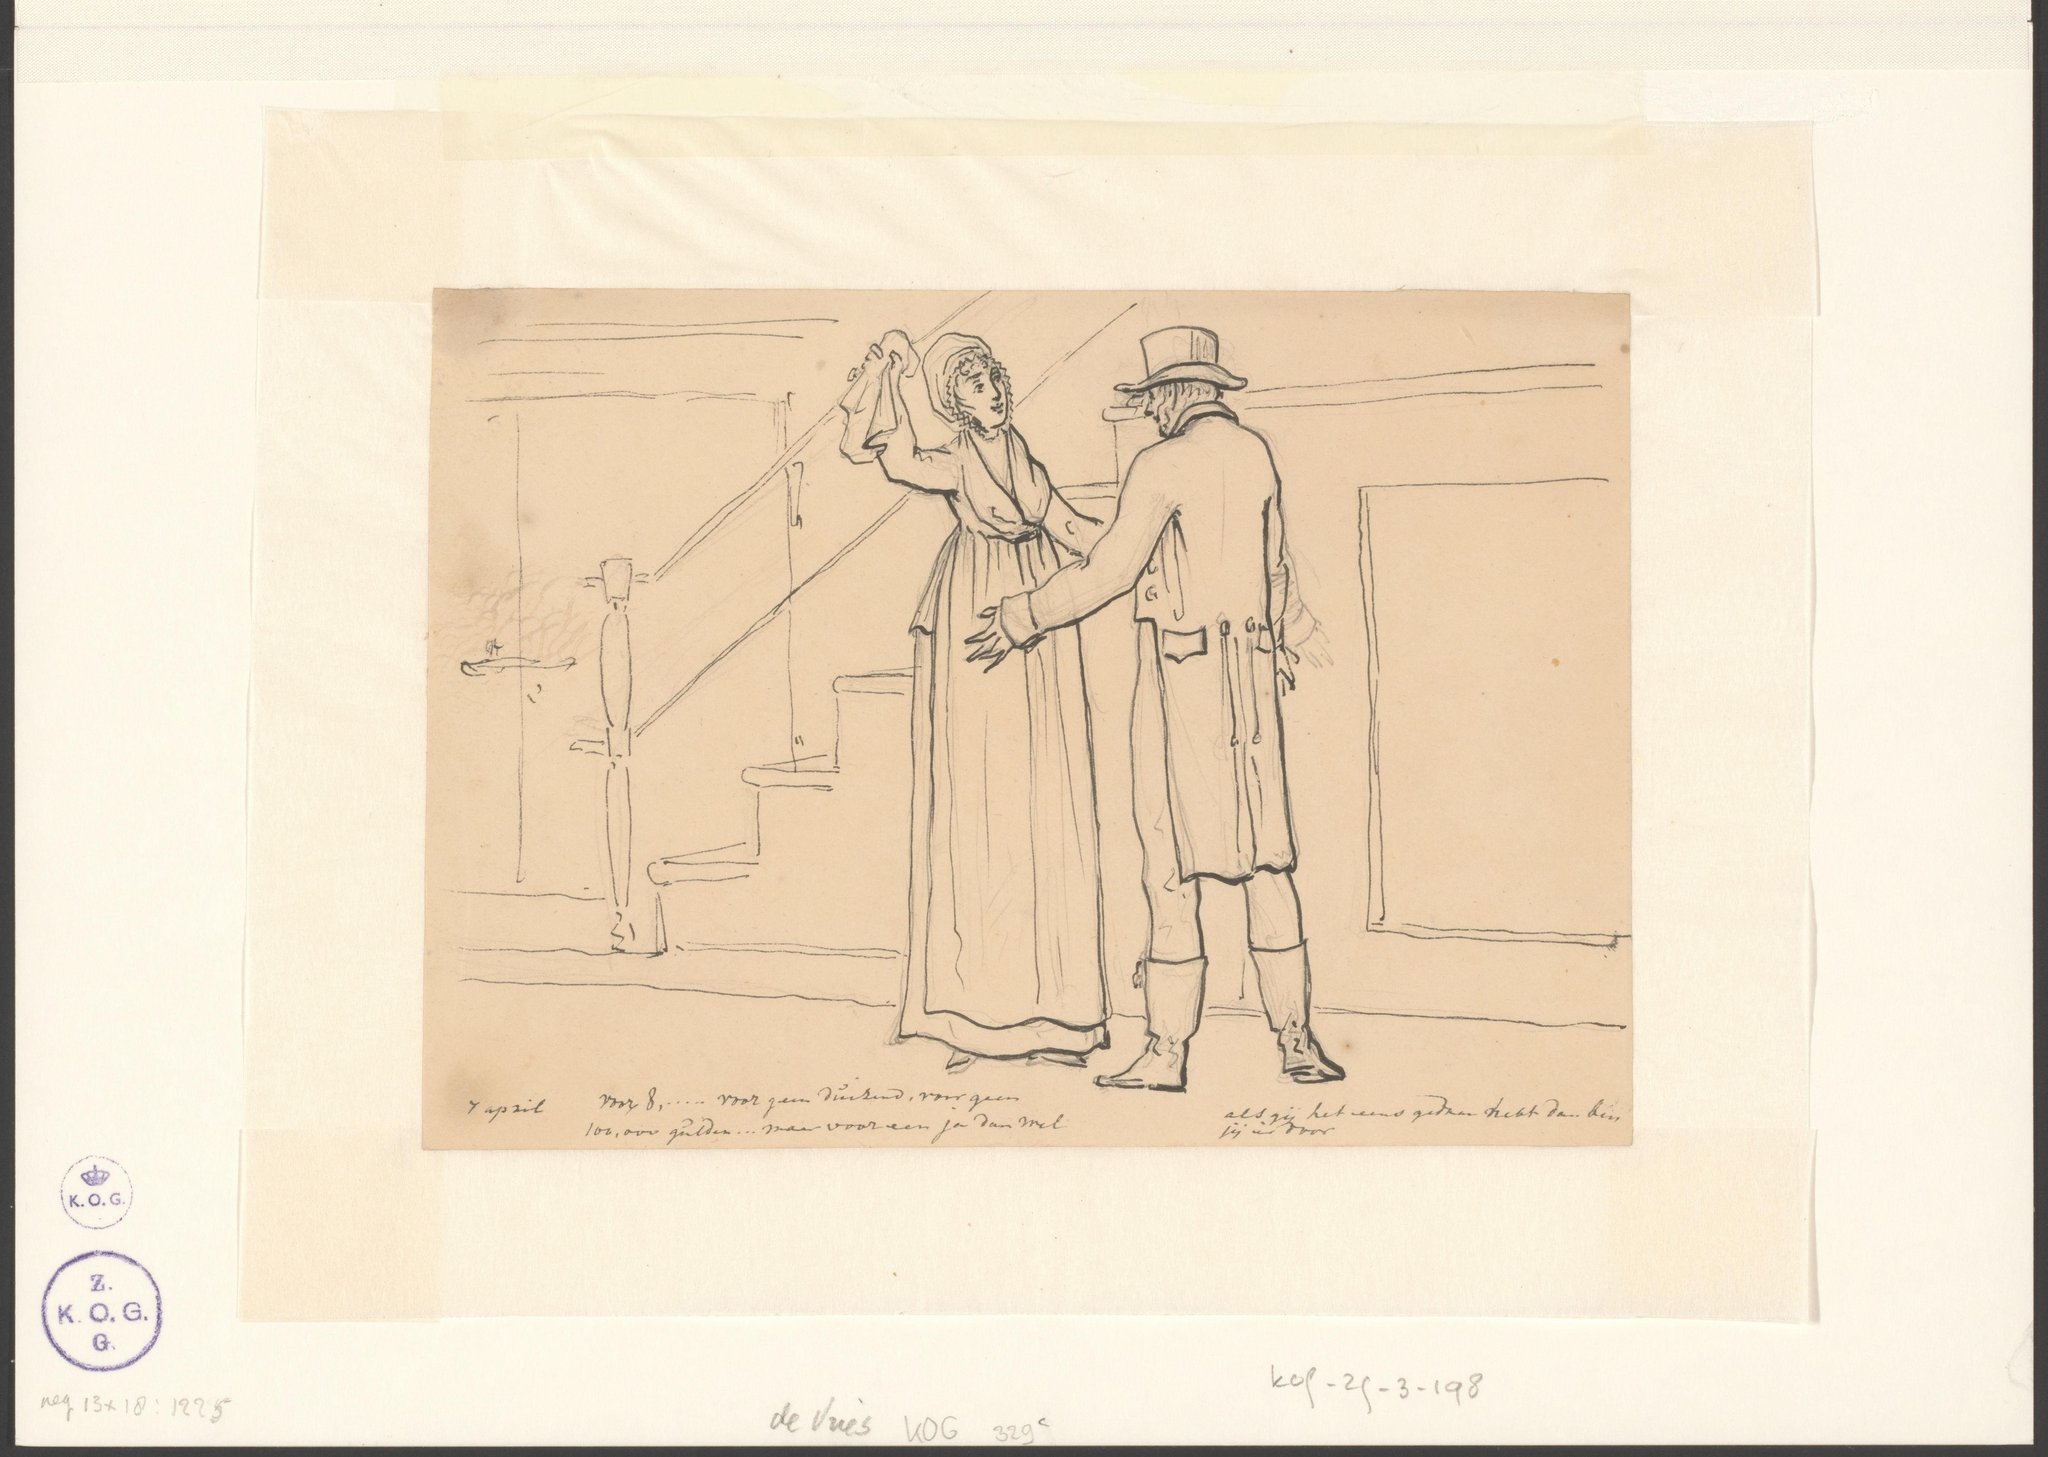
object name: drawing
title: Christiaan Andriessen vraagt een vrouw model te zitten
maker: christiaan andriessen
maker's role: draughtsman, print maker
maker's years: 1775-1846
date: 1805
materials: ink, paper, pencil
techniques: pen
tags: print maker, draughtsman, christiaan andriessen, painter working from live model, working situations ~ painter, amsterdam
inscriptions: signature: ‘J Andriessen’, collector's mark: Lugt 1641, collector's mark: Lugt 1641a, inscription: ‘7 april voor geen 8, ..... voor geen duizend, voor geen 100.000 gulden... maar voor een ja dan wel / als gij het eens gedaan hebt dan ben jij er voor’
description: Christiaan Andriessen vraagt een vrouw model te zitten, eerst wil zij niet, maar later bedenkt zij zich.